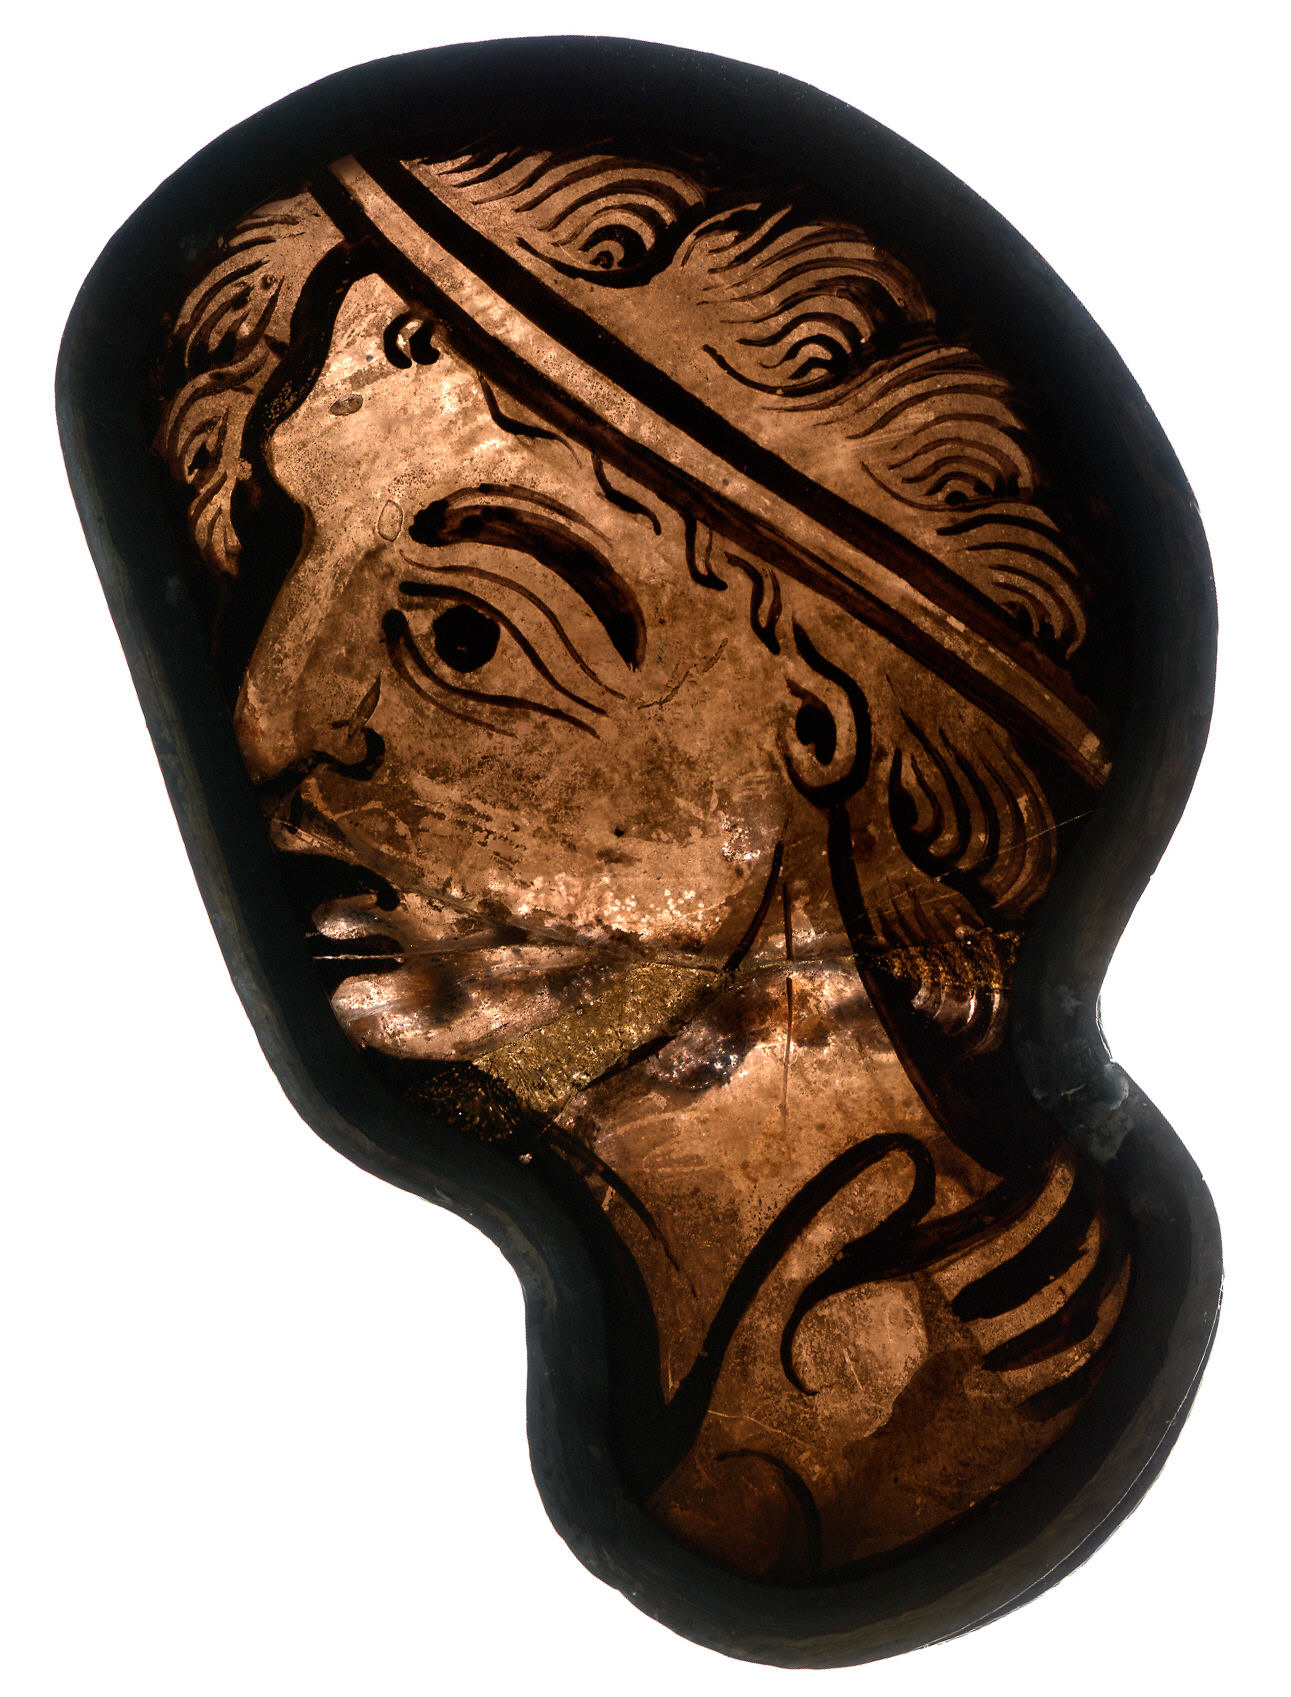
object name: fragment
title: Glass Fragment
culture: french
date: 1200-1215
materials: glass, metal, paint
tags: men